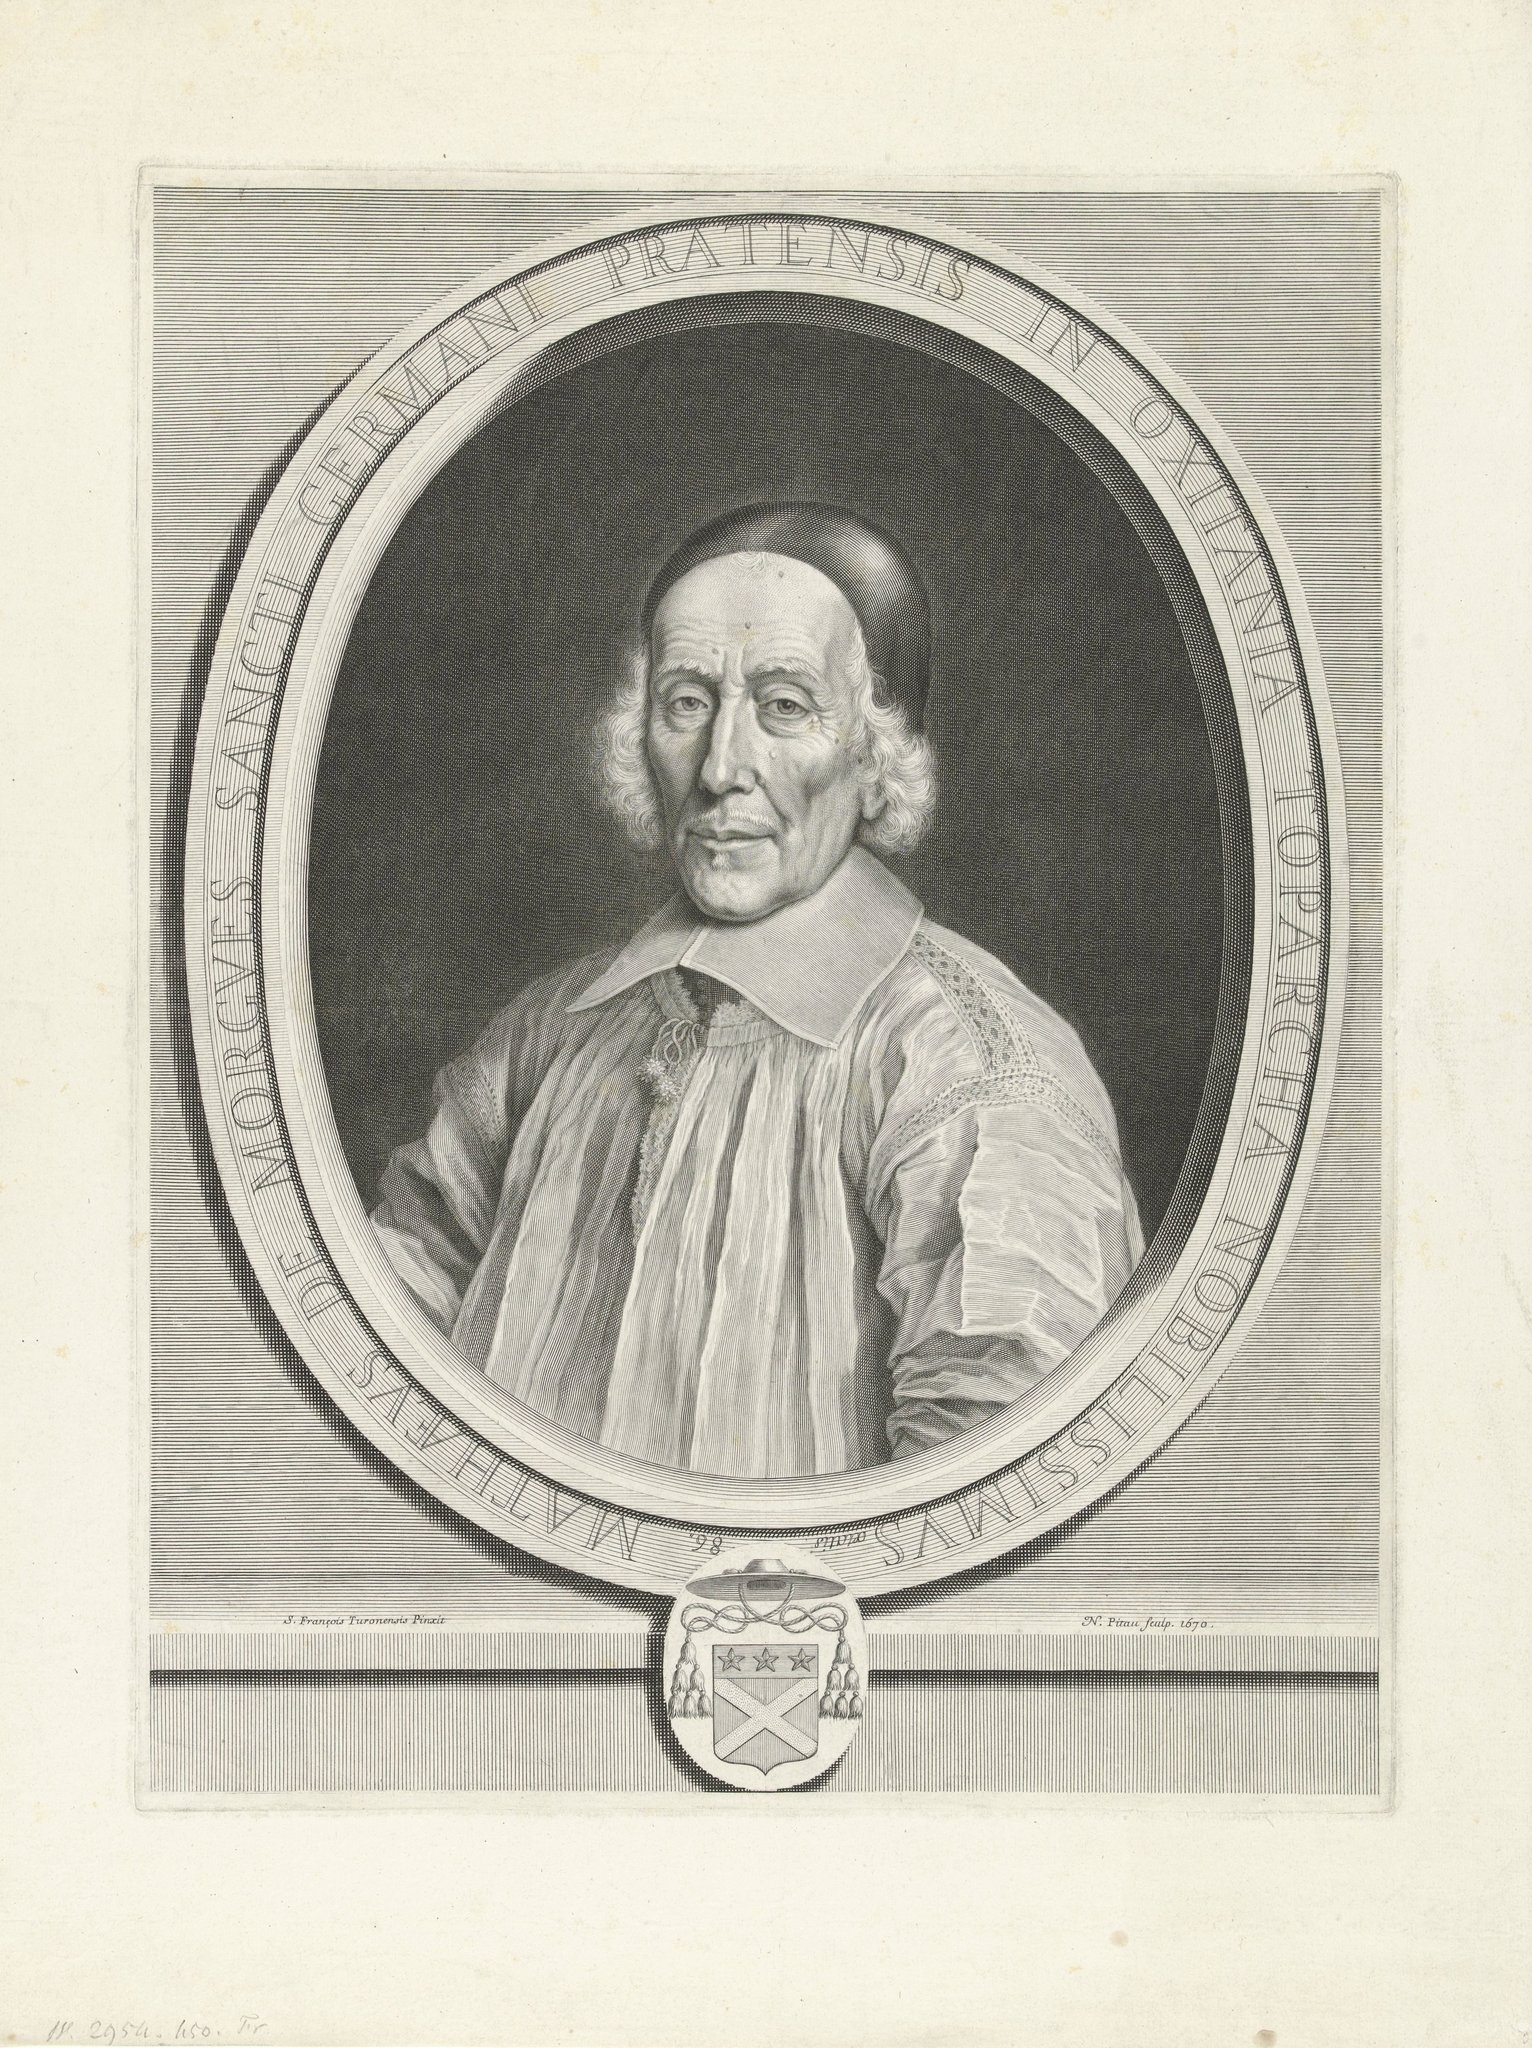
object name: print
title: Portret van Matthieu de Morgues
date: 1670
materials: paper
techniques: engraving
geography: paris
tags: abt, matthieu de morgues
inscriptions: collector's mark: Lugt 240, number: ‘73 - 12’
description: Portret van abt Matthieu de Morgues, seigneur de Prat, op 86-jarige leeftijd. Onder de omlijsting zijn wapen.